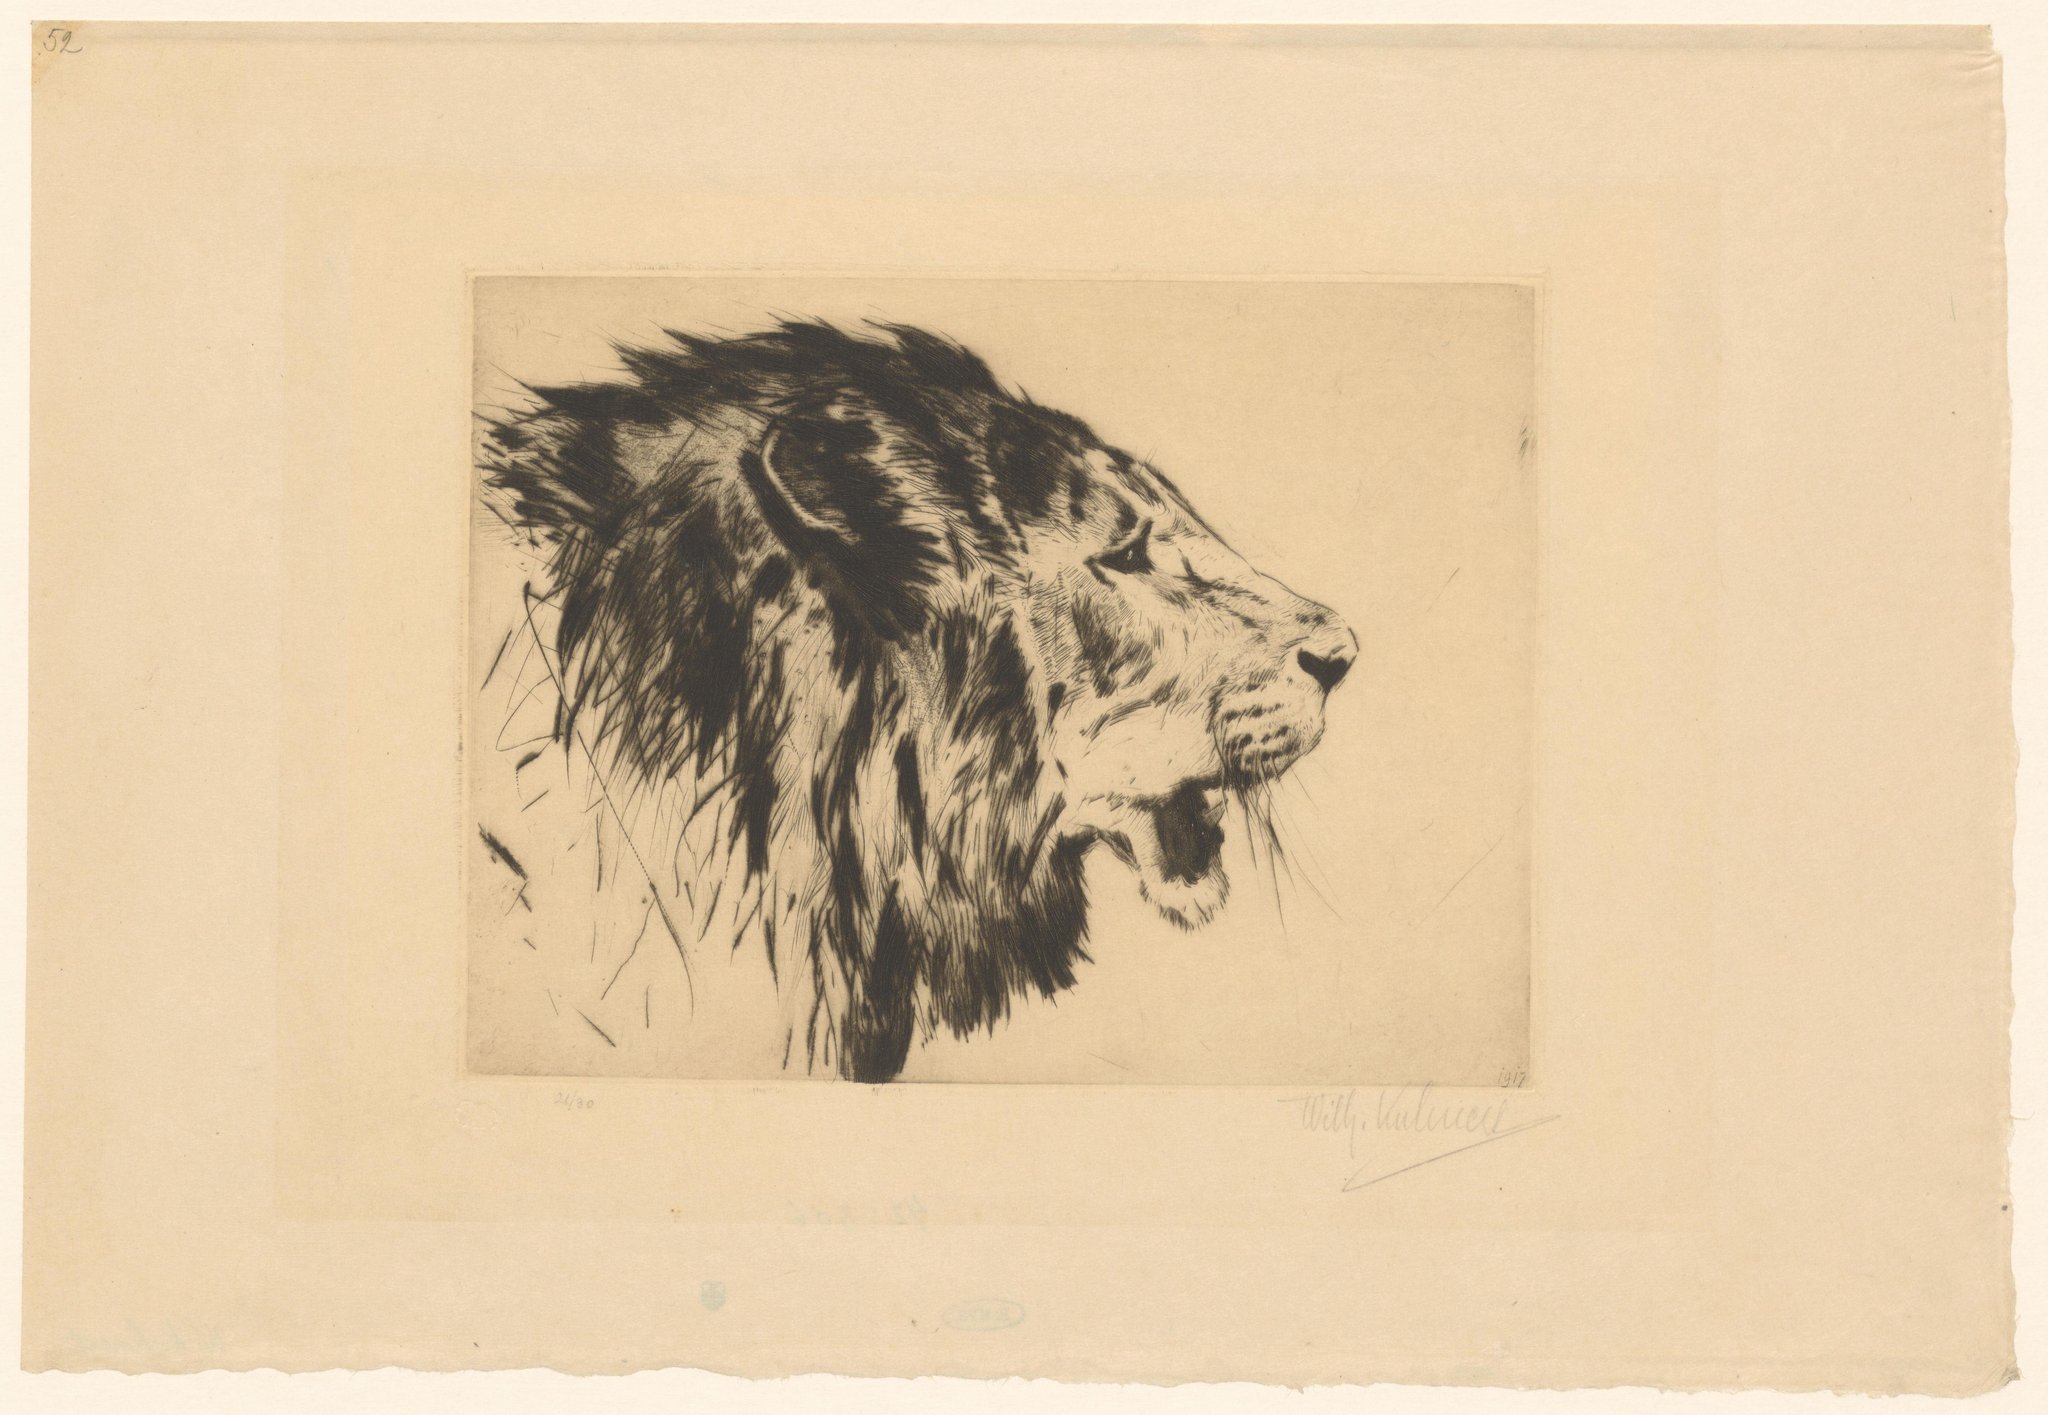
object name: print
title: Leeuwenkop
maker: wilhelm kuhnert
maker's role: painter, print maker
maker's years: 1865-1926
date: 1917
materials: paper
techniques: drypoint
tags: lion's head ~ ornament, beasts of prey, predatory animals: lion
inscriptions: signature: ‘Wilh. Kuhnert’, collector's mark: Lugt 2228, collector's mark: Lugt 2760, number: ‘21/30’